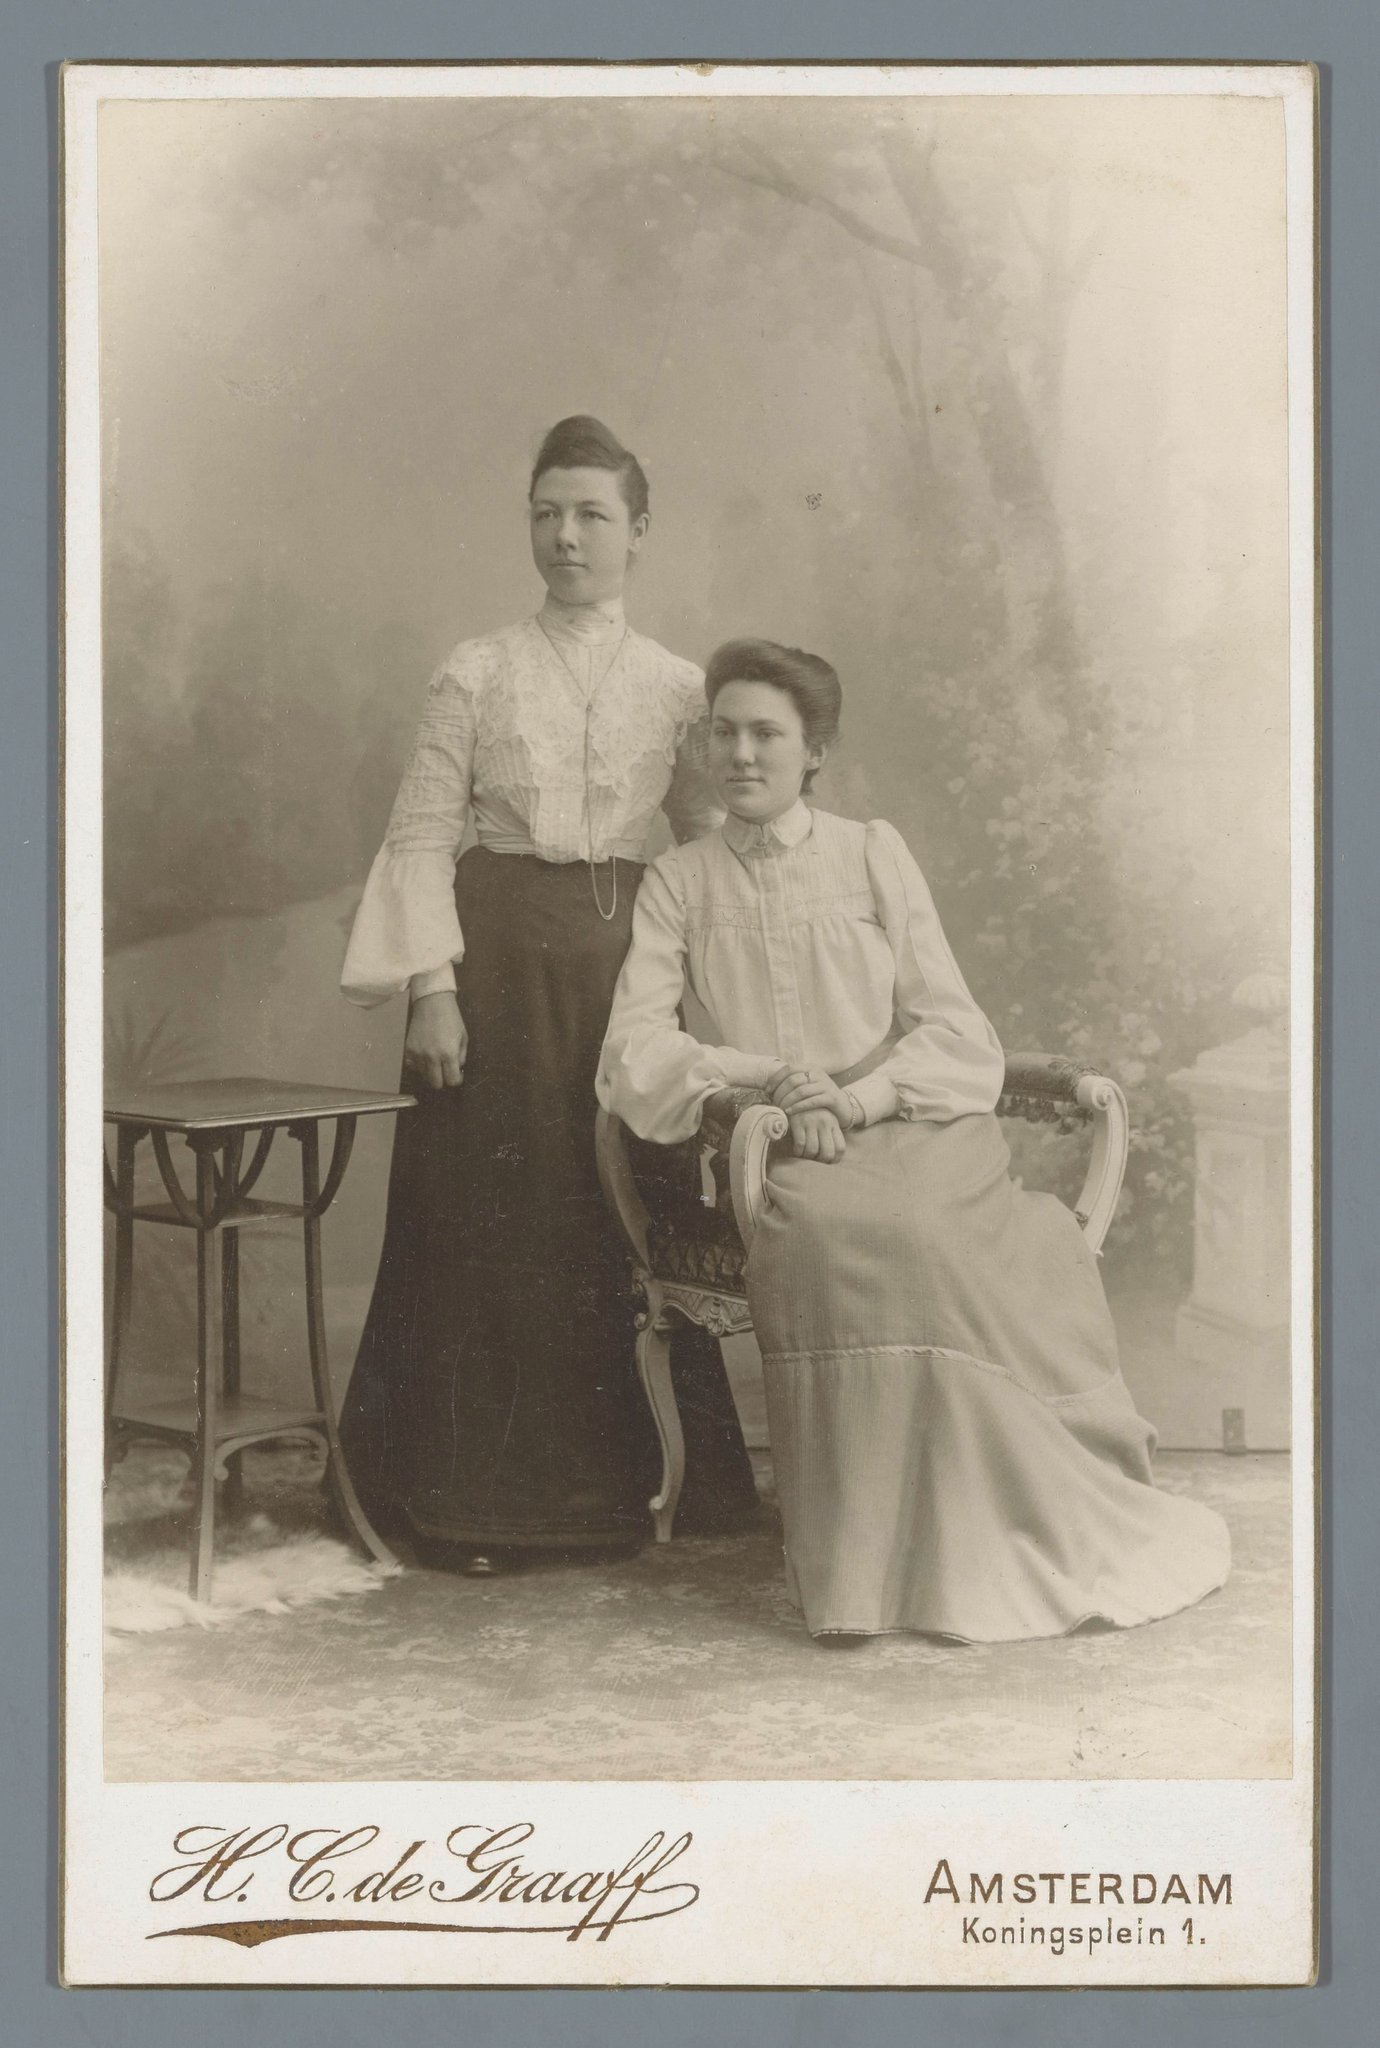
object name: cabinet photograph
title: Portret van twee onbekende vrouwen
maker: h.c. de graaff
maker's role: fotograaf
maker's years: 1853-1932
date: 1882-1922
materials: cardboard, photographic support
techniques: gelatin silver print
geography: amsterdam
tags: adult woman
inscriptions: name: ‘Photographie Societé anonyme Dir. H.C.. de Graaff Koningsplein gebouw “Kosmos” Amsterdam. (...)’